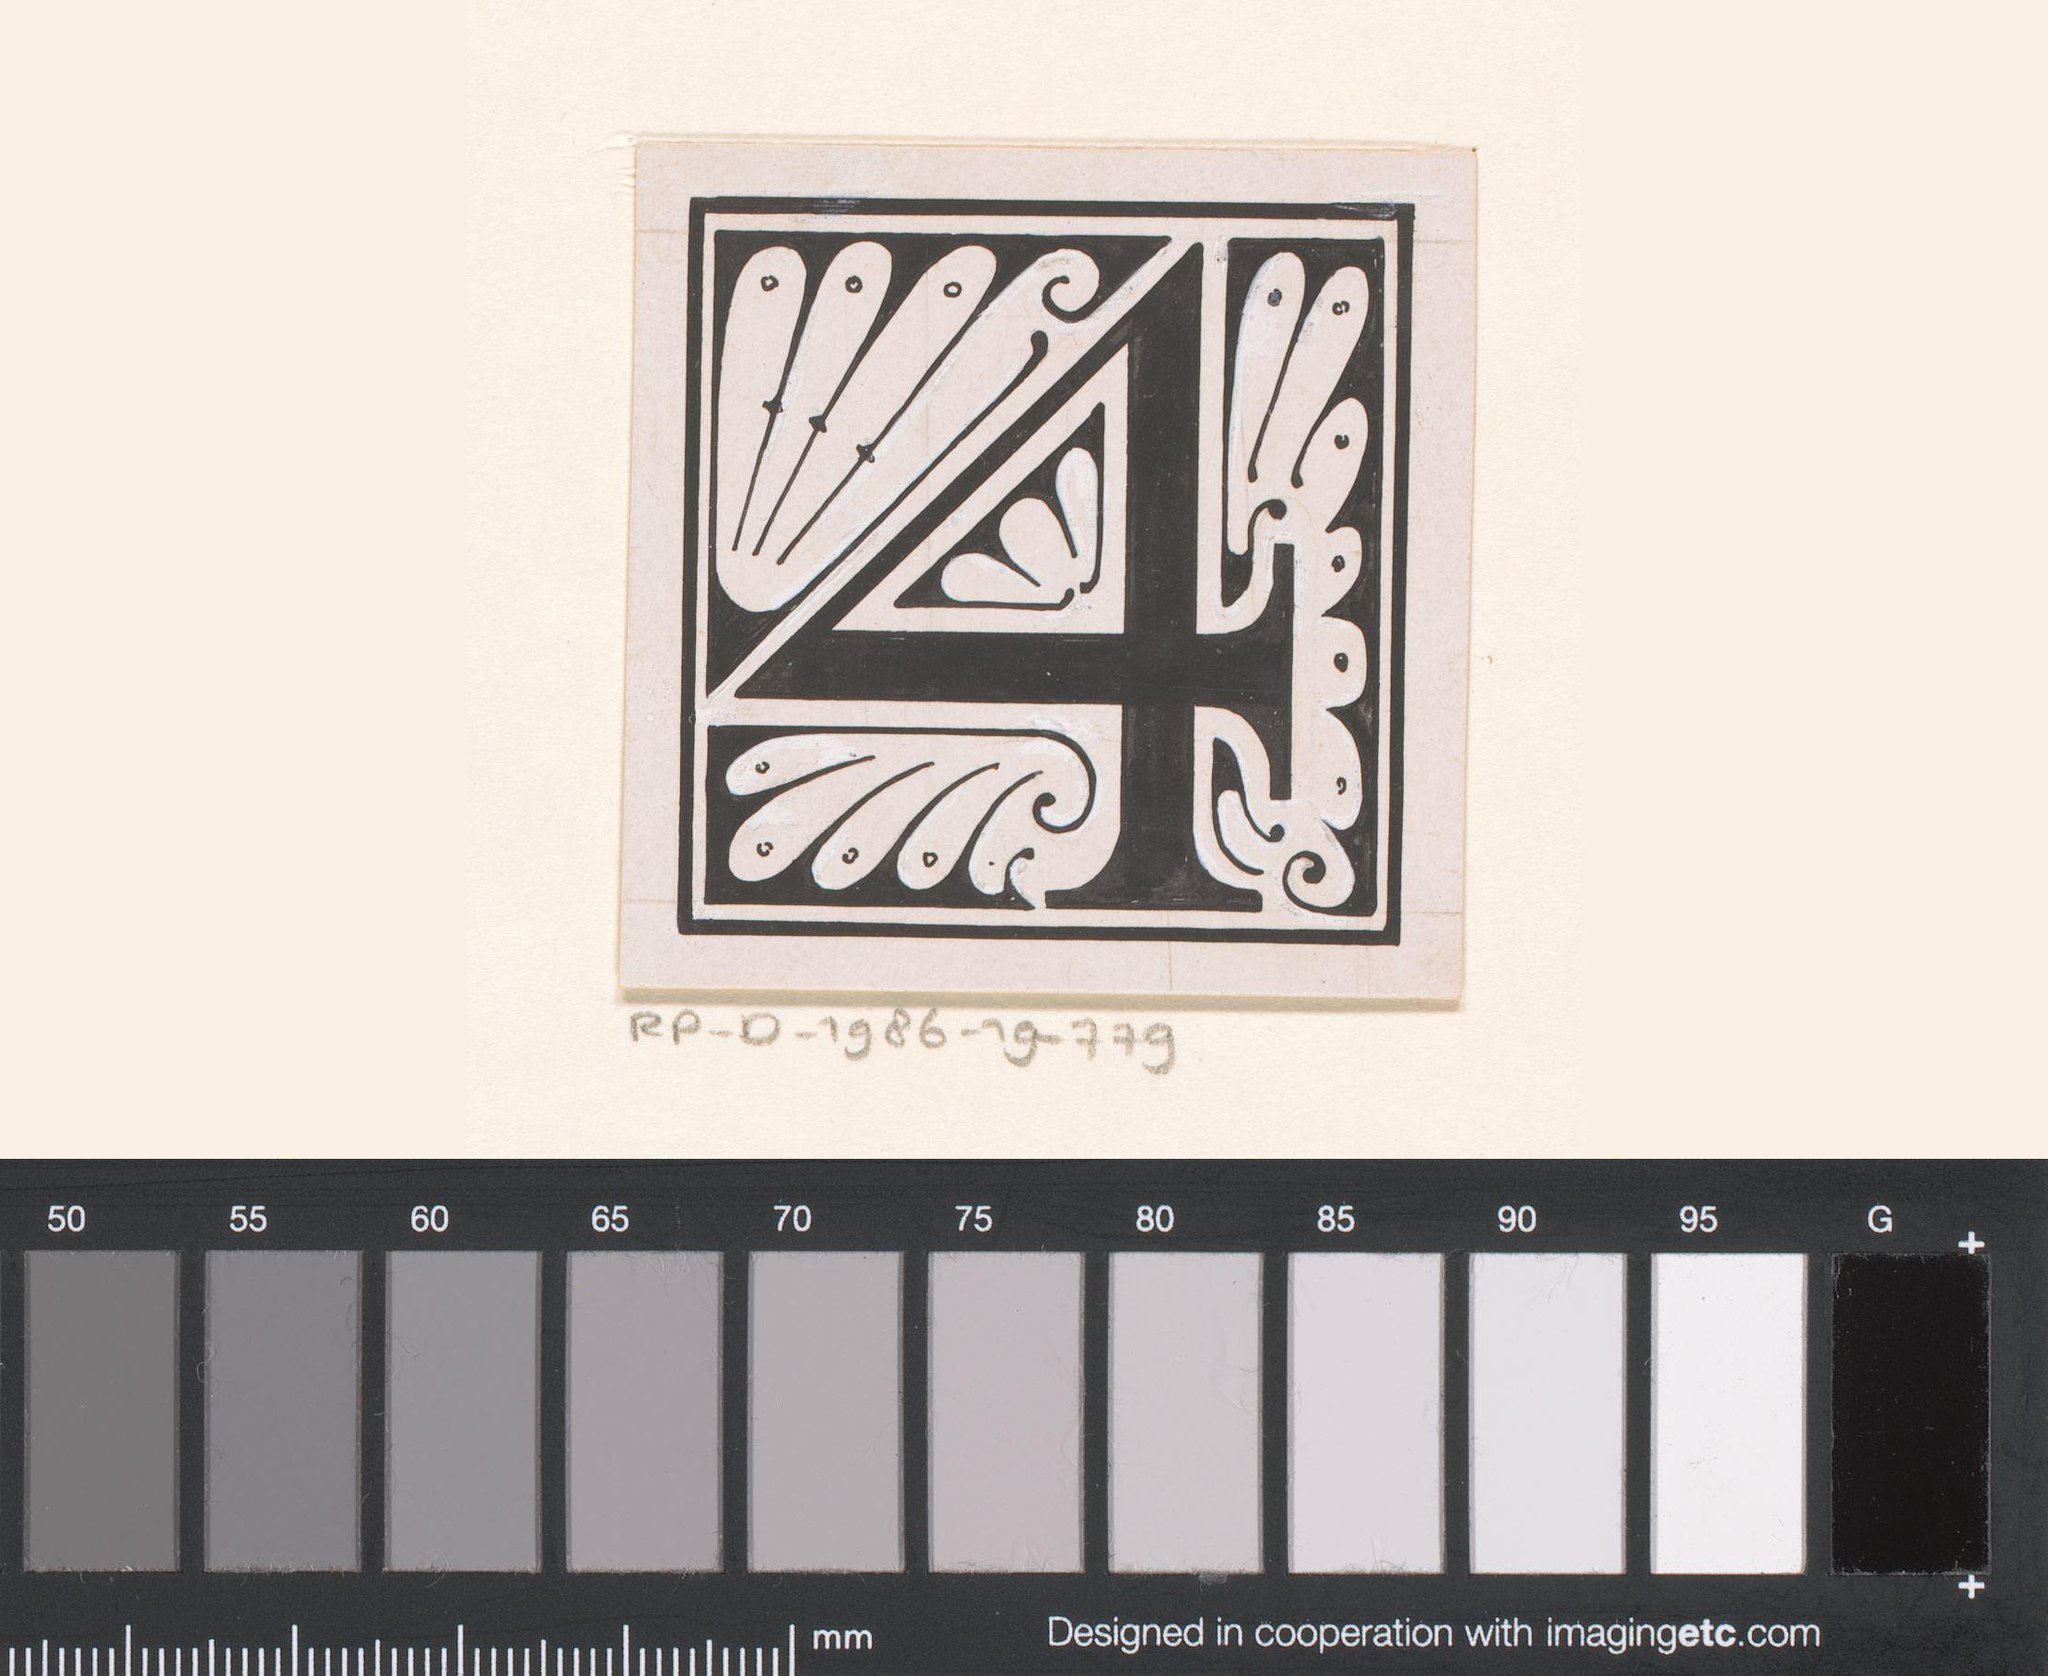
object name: drawing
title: Getal 4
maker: reinier willem petrus de vries (1874-1953)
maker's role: draughtsman, print maker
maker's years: 1874-1953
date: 1904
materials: paint, ink, paper, pencil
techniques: brush, pen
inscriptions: collector's mark: ‘R:MVS.’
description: Het getal is gebruikt voor: Veth, Jan. Jozef Israëls en zijn kunst. Arnhem en Nijmegen: Gebroeders E&M Cohen, 1904.